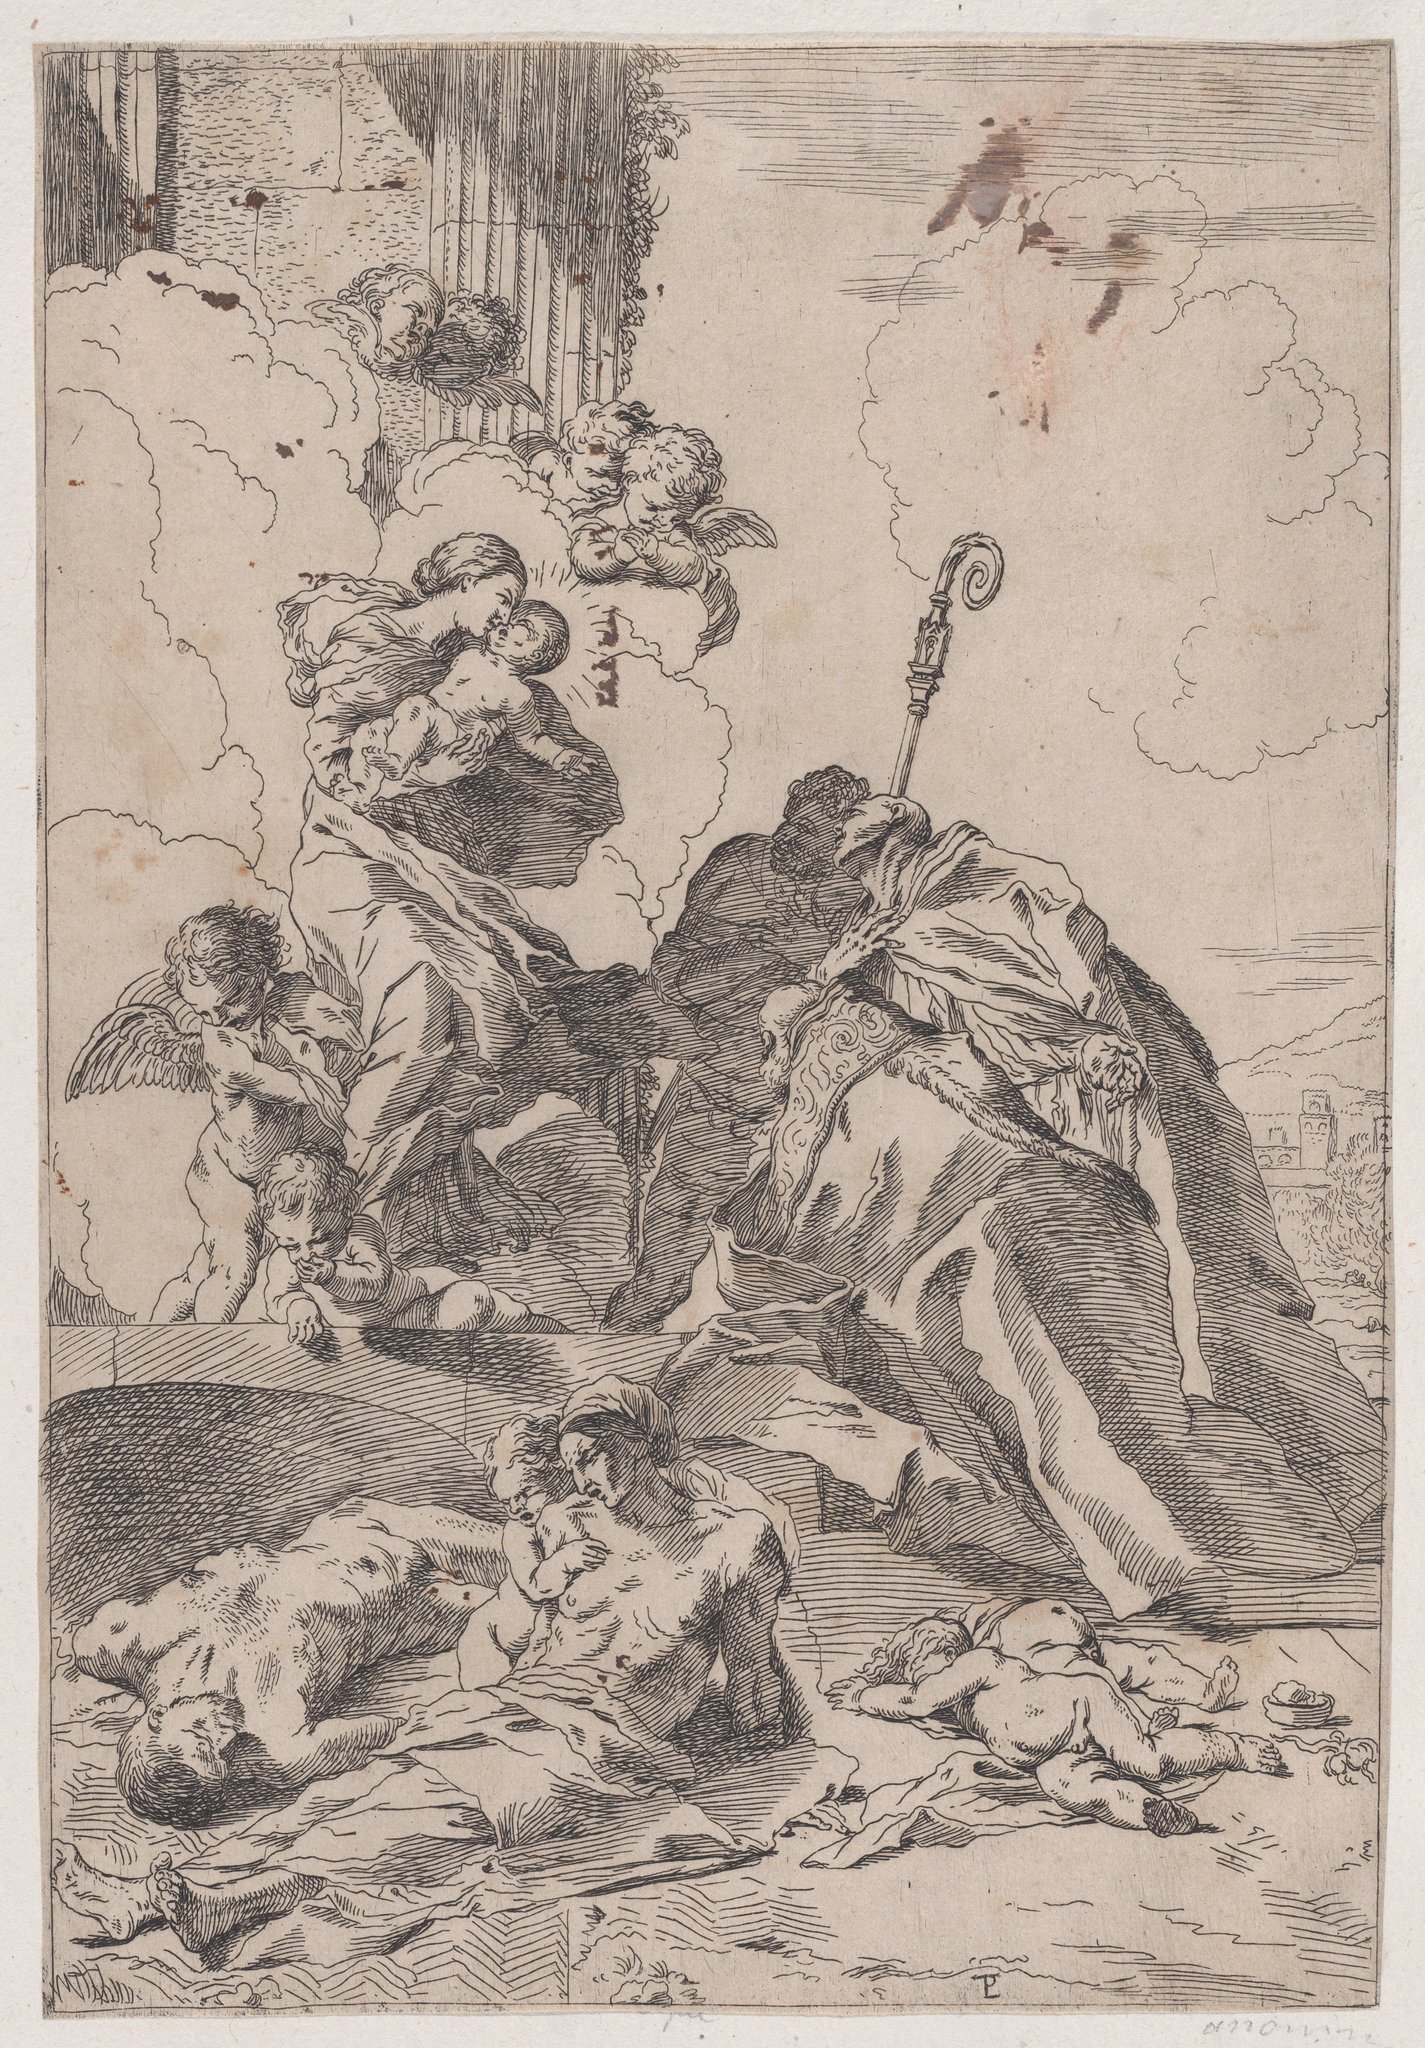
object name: print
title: Three Lucchese saints Sts Nicholas Tolentino, Nicholas of Bari interceding with the Virgin for the victims of the plague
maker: anonymous, 17th century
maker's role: artist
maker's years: 1600-1700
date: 1650-1700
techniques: etching